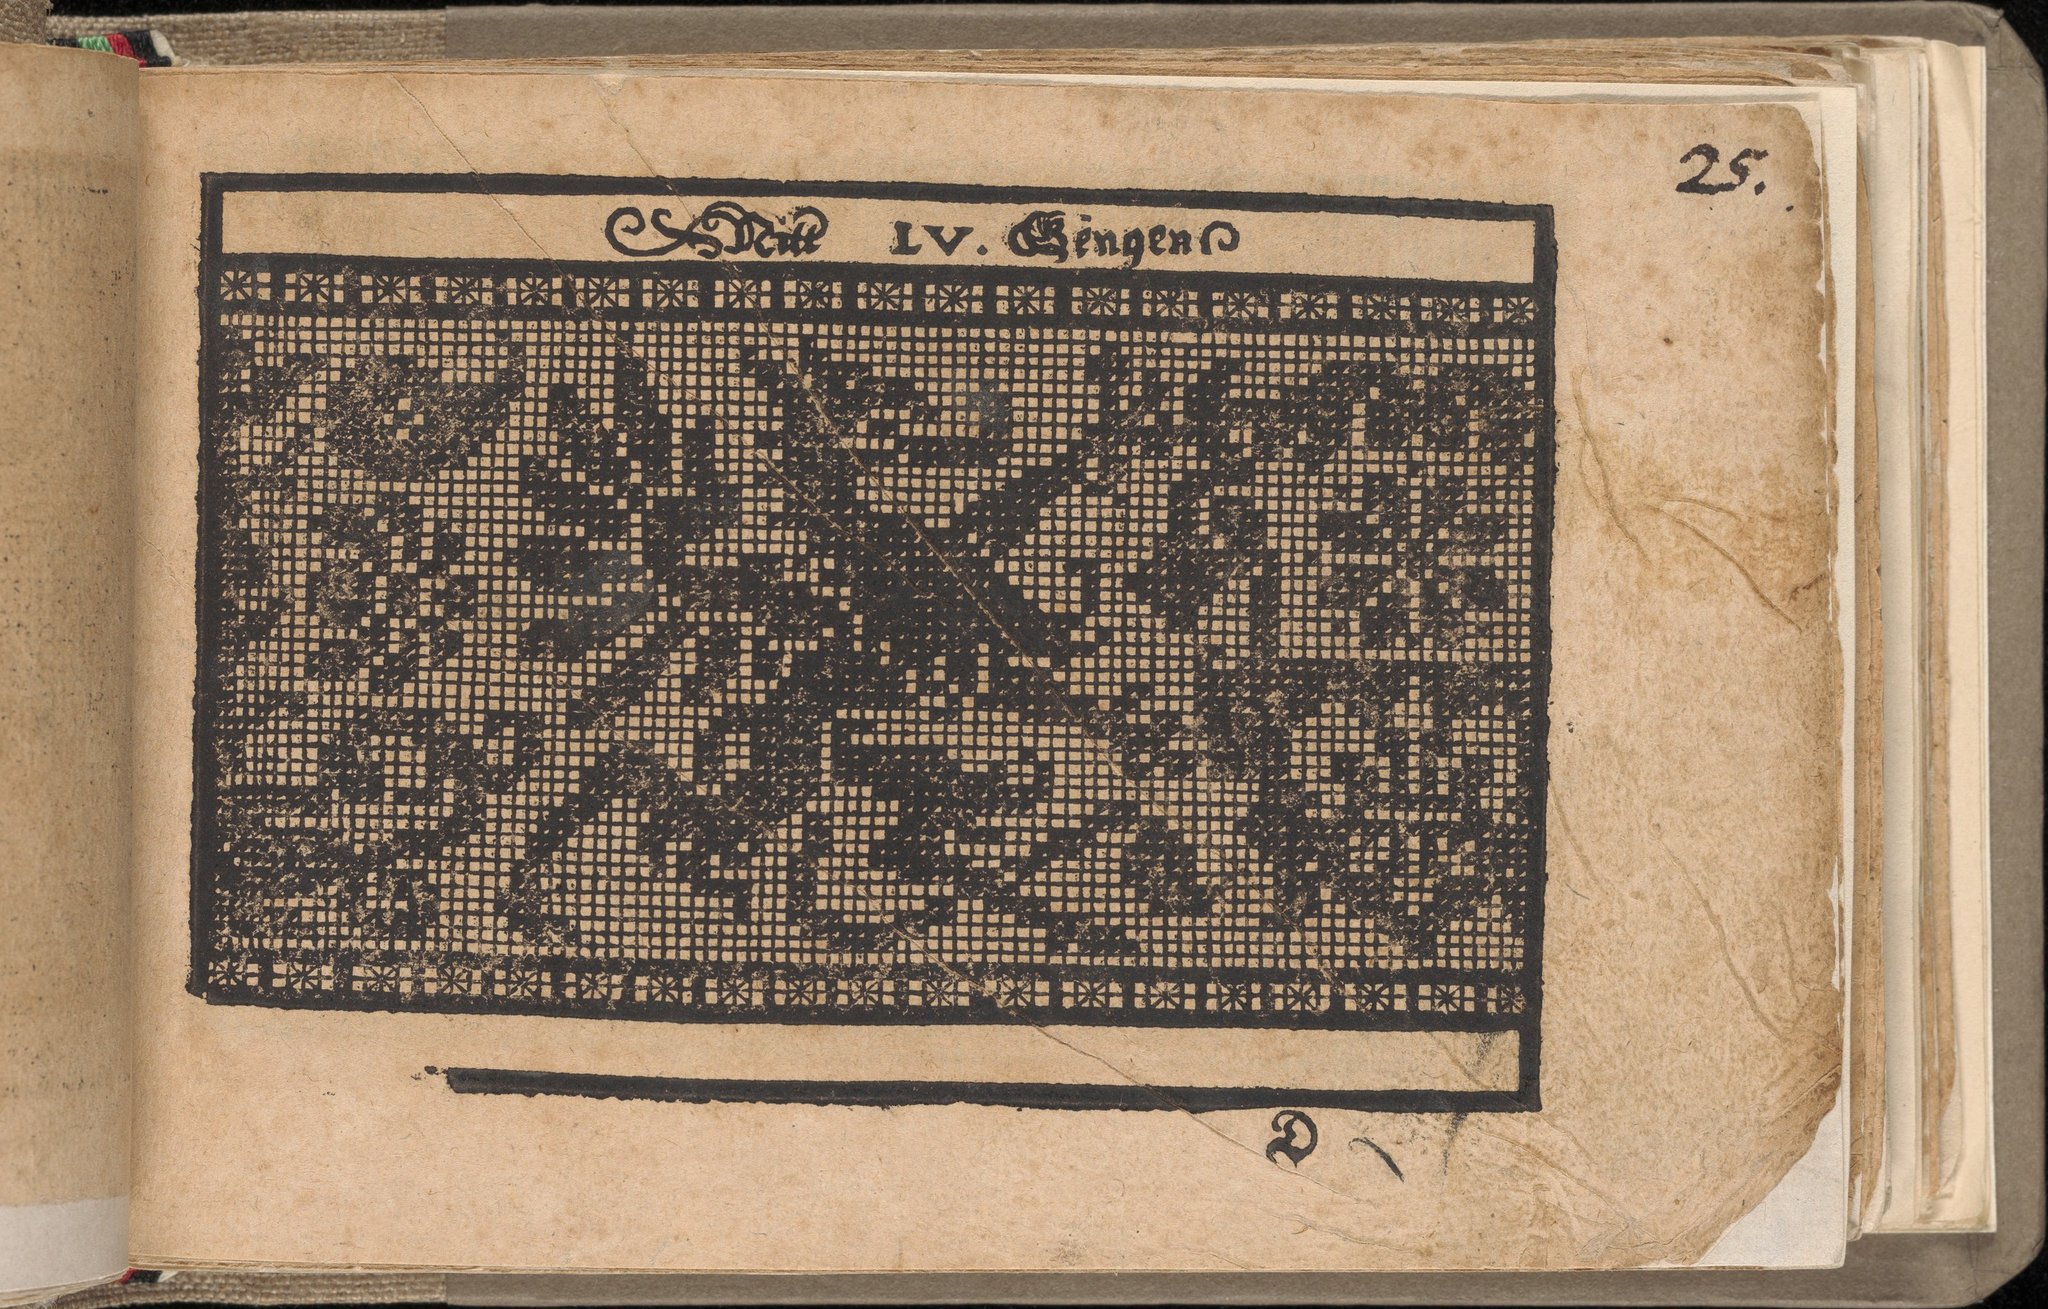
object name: book print ornament architecture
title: Schön newes Modelbuch (Page 25r)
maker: sigismundus latomus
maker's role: publisher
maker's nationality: german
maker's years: 1599-1632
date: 1608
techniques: woodcut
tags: ornament